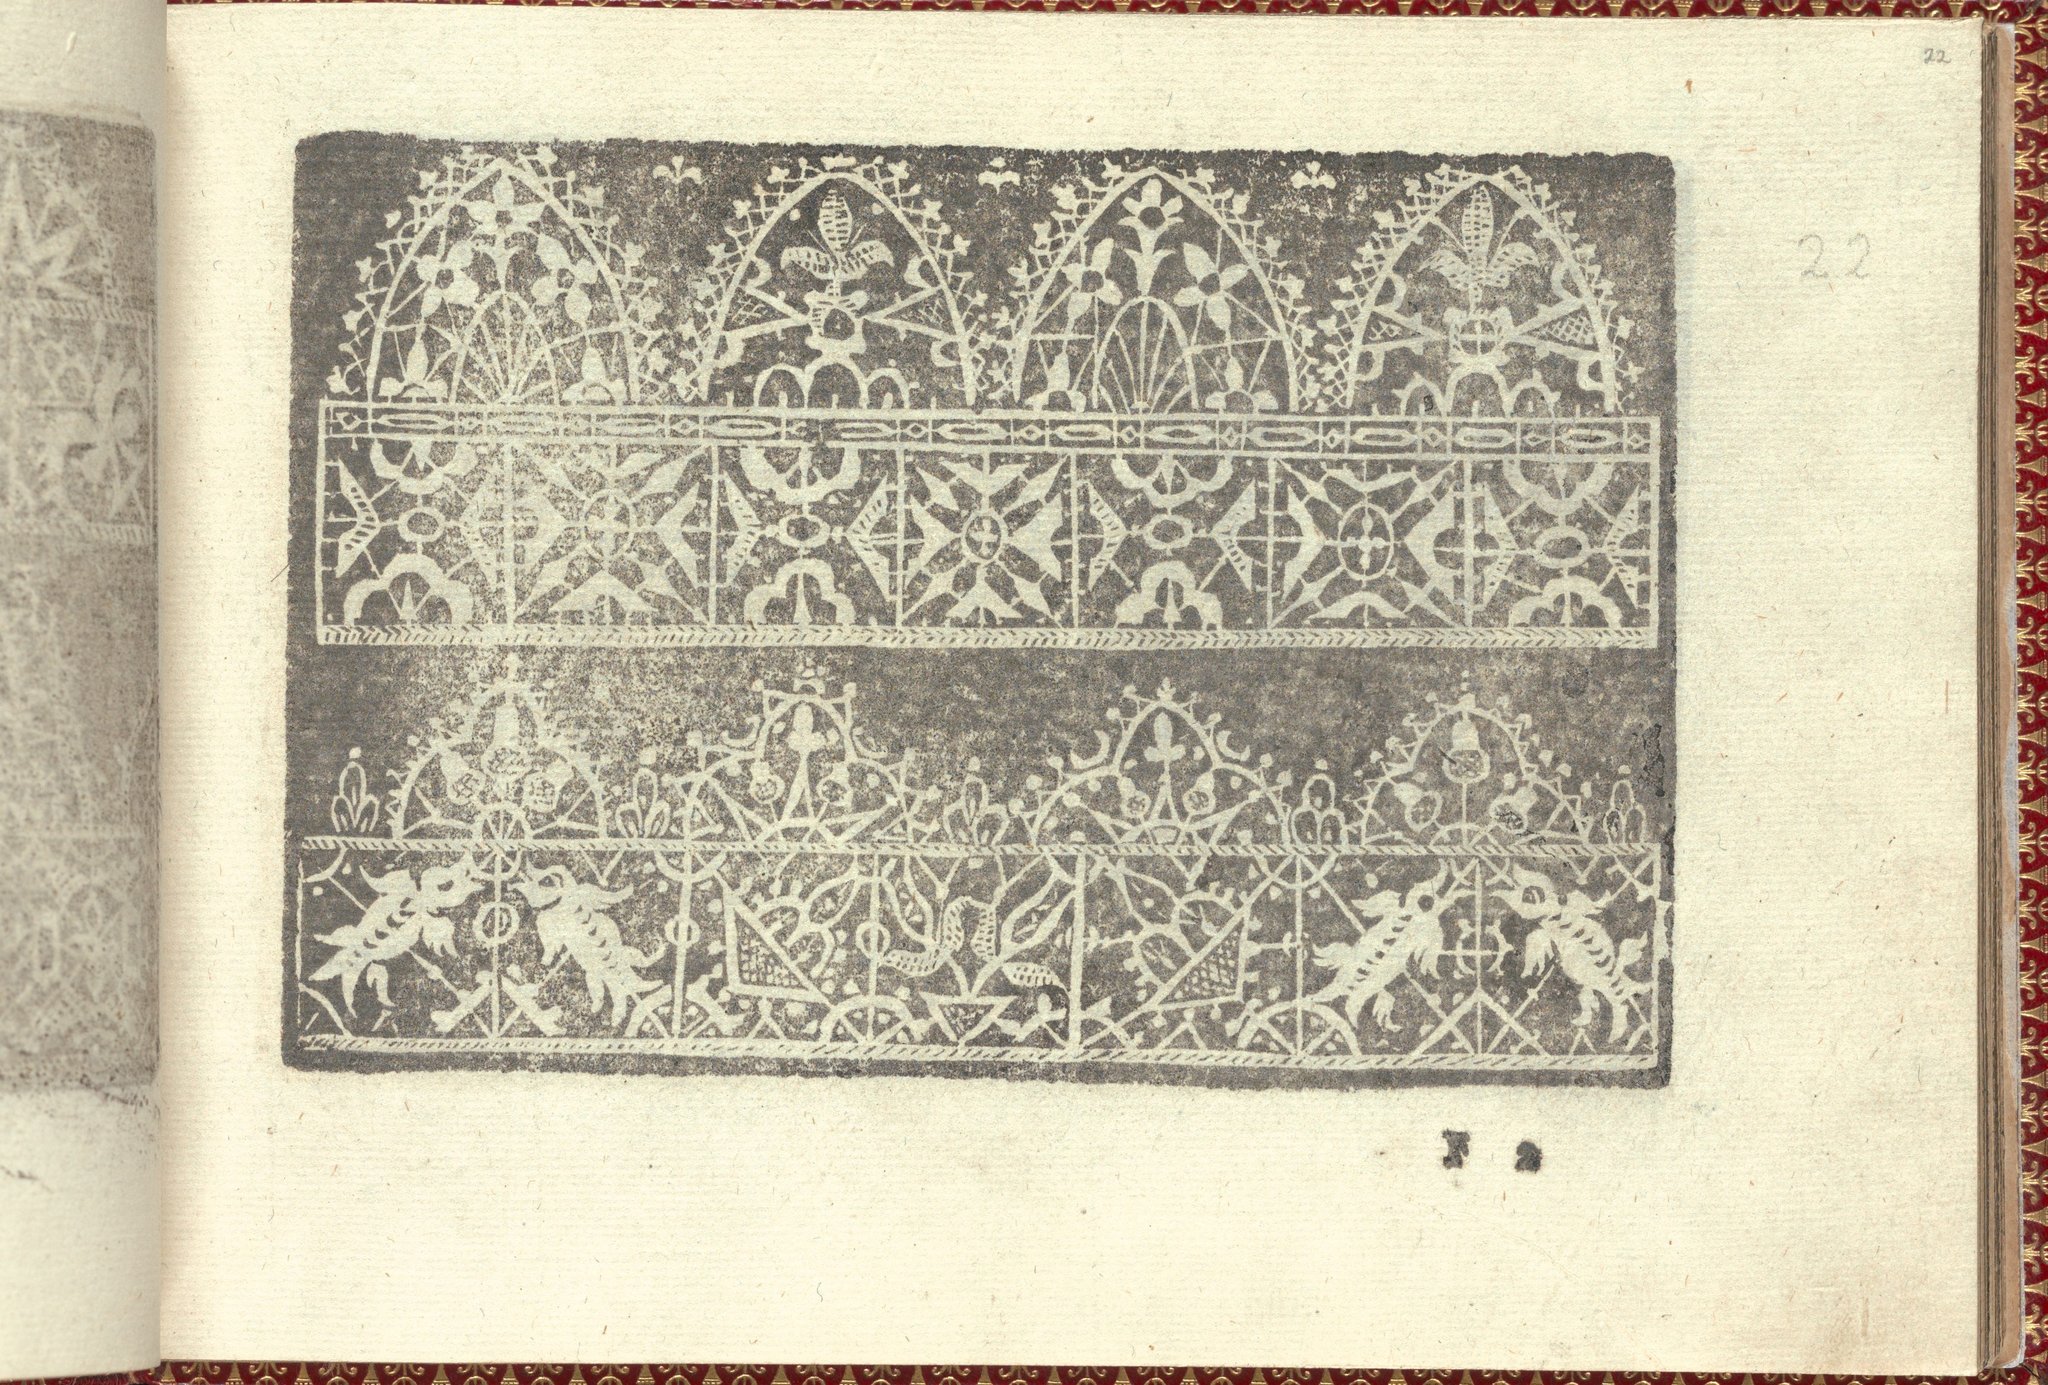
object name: book print ornament architecture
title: Corona delle Nobili et Virtuose Donne: Libro I-IV, page 22 (recto)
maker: cesare vecellio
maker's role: publisher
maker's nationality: italian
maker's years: 1521-1601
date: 1601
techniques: woodcut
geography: italy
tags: fish,flowers